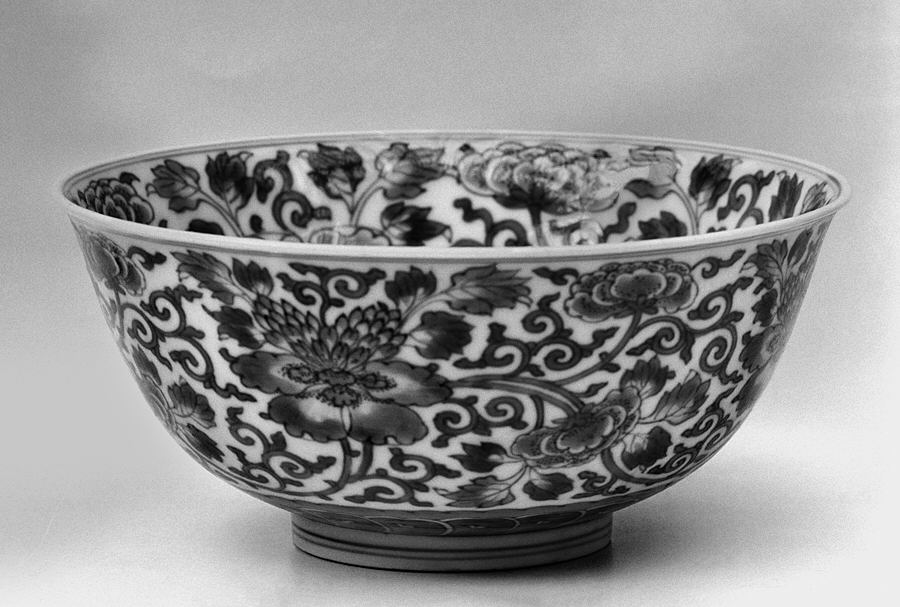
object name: bowl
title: Bowl with flowers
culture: chinese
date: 1667-1733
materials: cobalt, porcelain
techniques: painting, underglaze